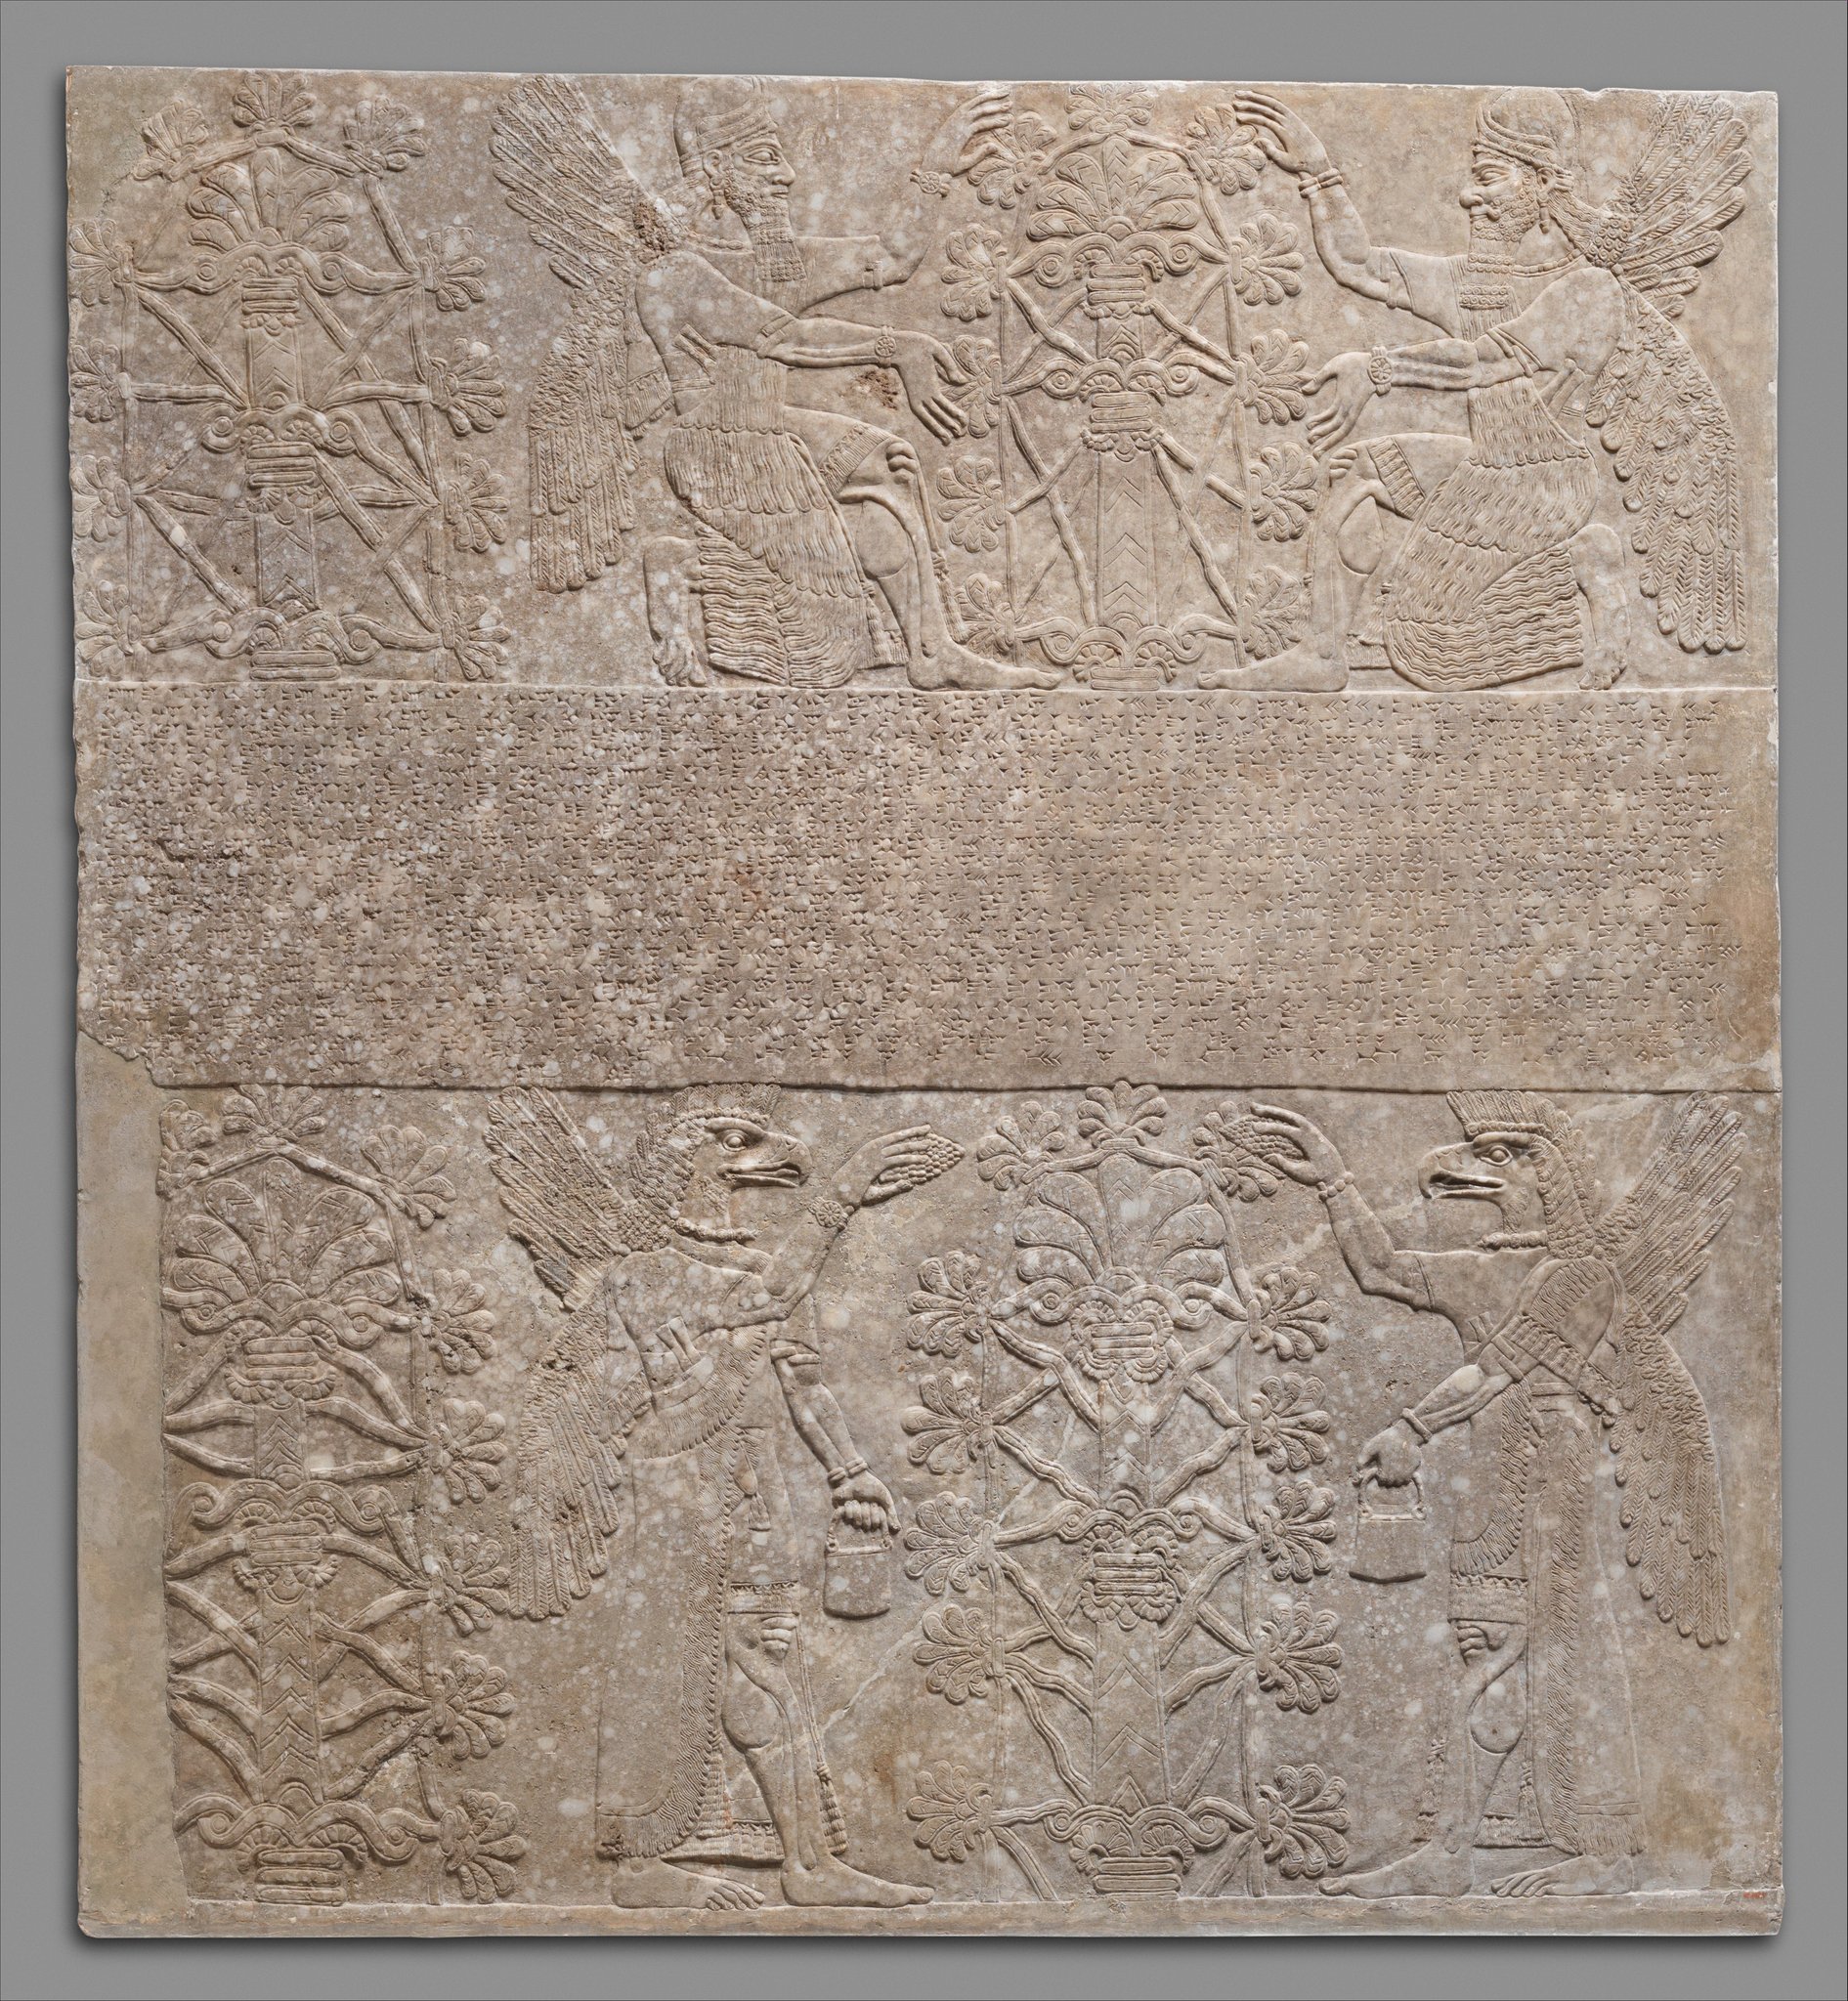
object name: relief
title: Relief panel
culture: assyrian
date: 883-859 BCE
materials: alabaster, gypsum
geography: mesopotamia